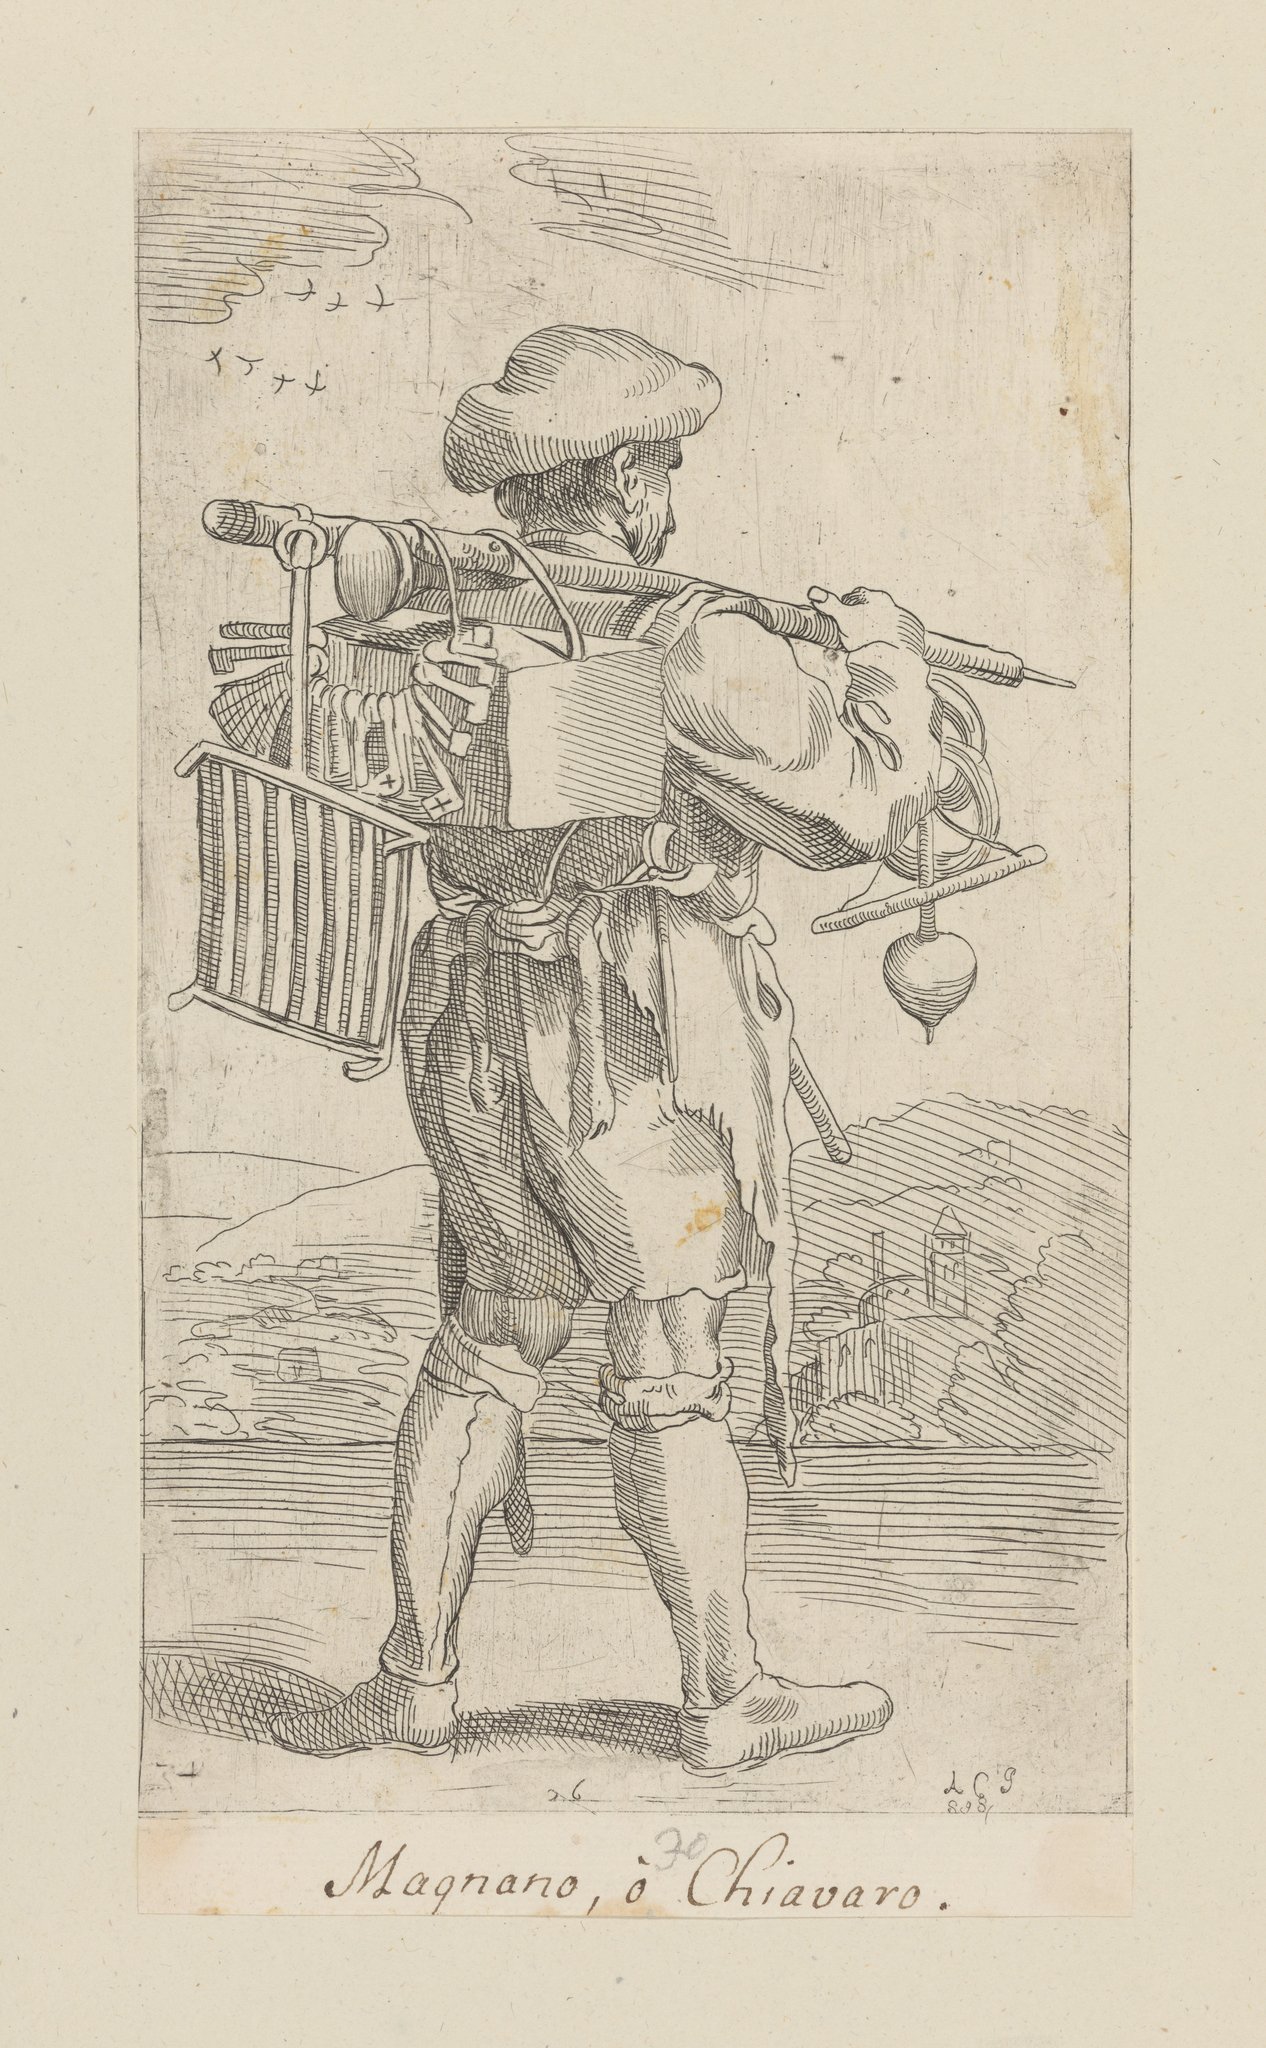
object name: print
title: Plate 26: locksmith and plumber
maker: simon guillain ii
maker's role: artist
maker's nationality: french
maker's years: 1618-1718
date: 1646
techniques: etching